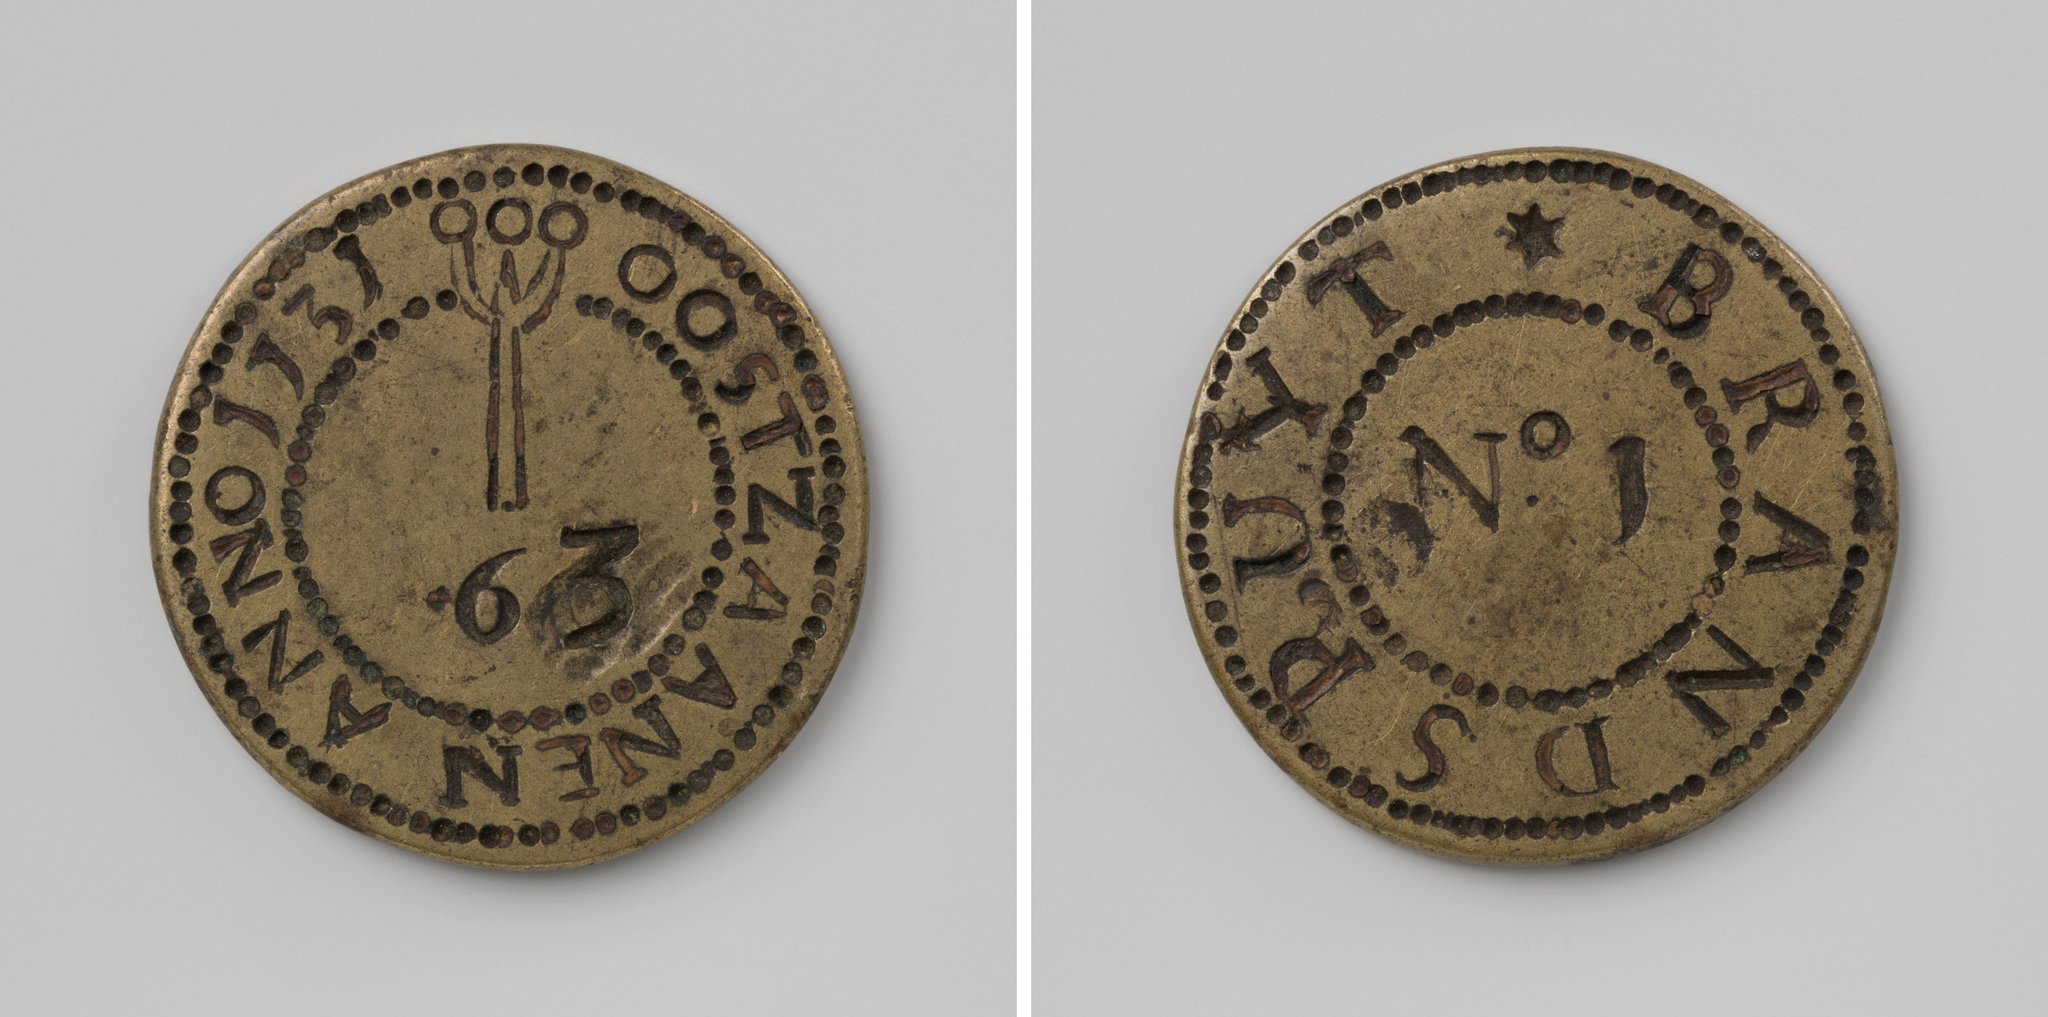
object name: fire engine medal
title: Oostzaan, brandspuitpenning van spuit 1 met no. 63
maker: Anonymous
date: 1731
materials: brass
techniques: engraving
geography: oostzaan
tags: oostzaan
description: Messing penning. Voorzijde: drietandige hooivork boven no. 63 binnen omschrift. Keerzijde: cijfer no. 1 binnen omschrift